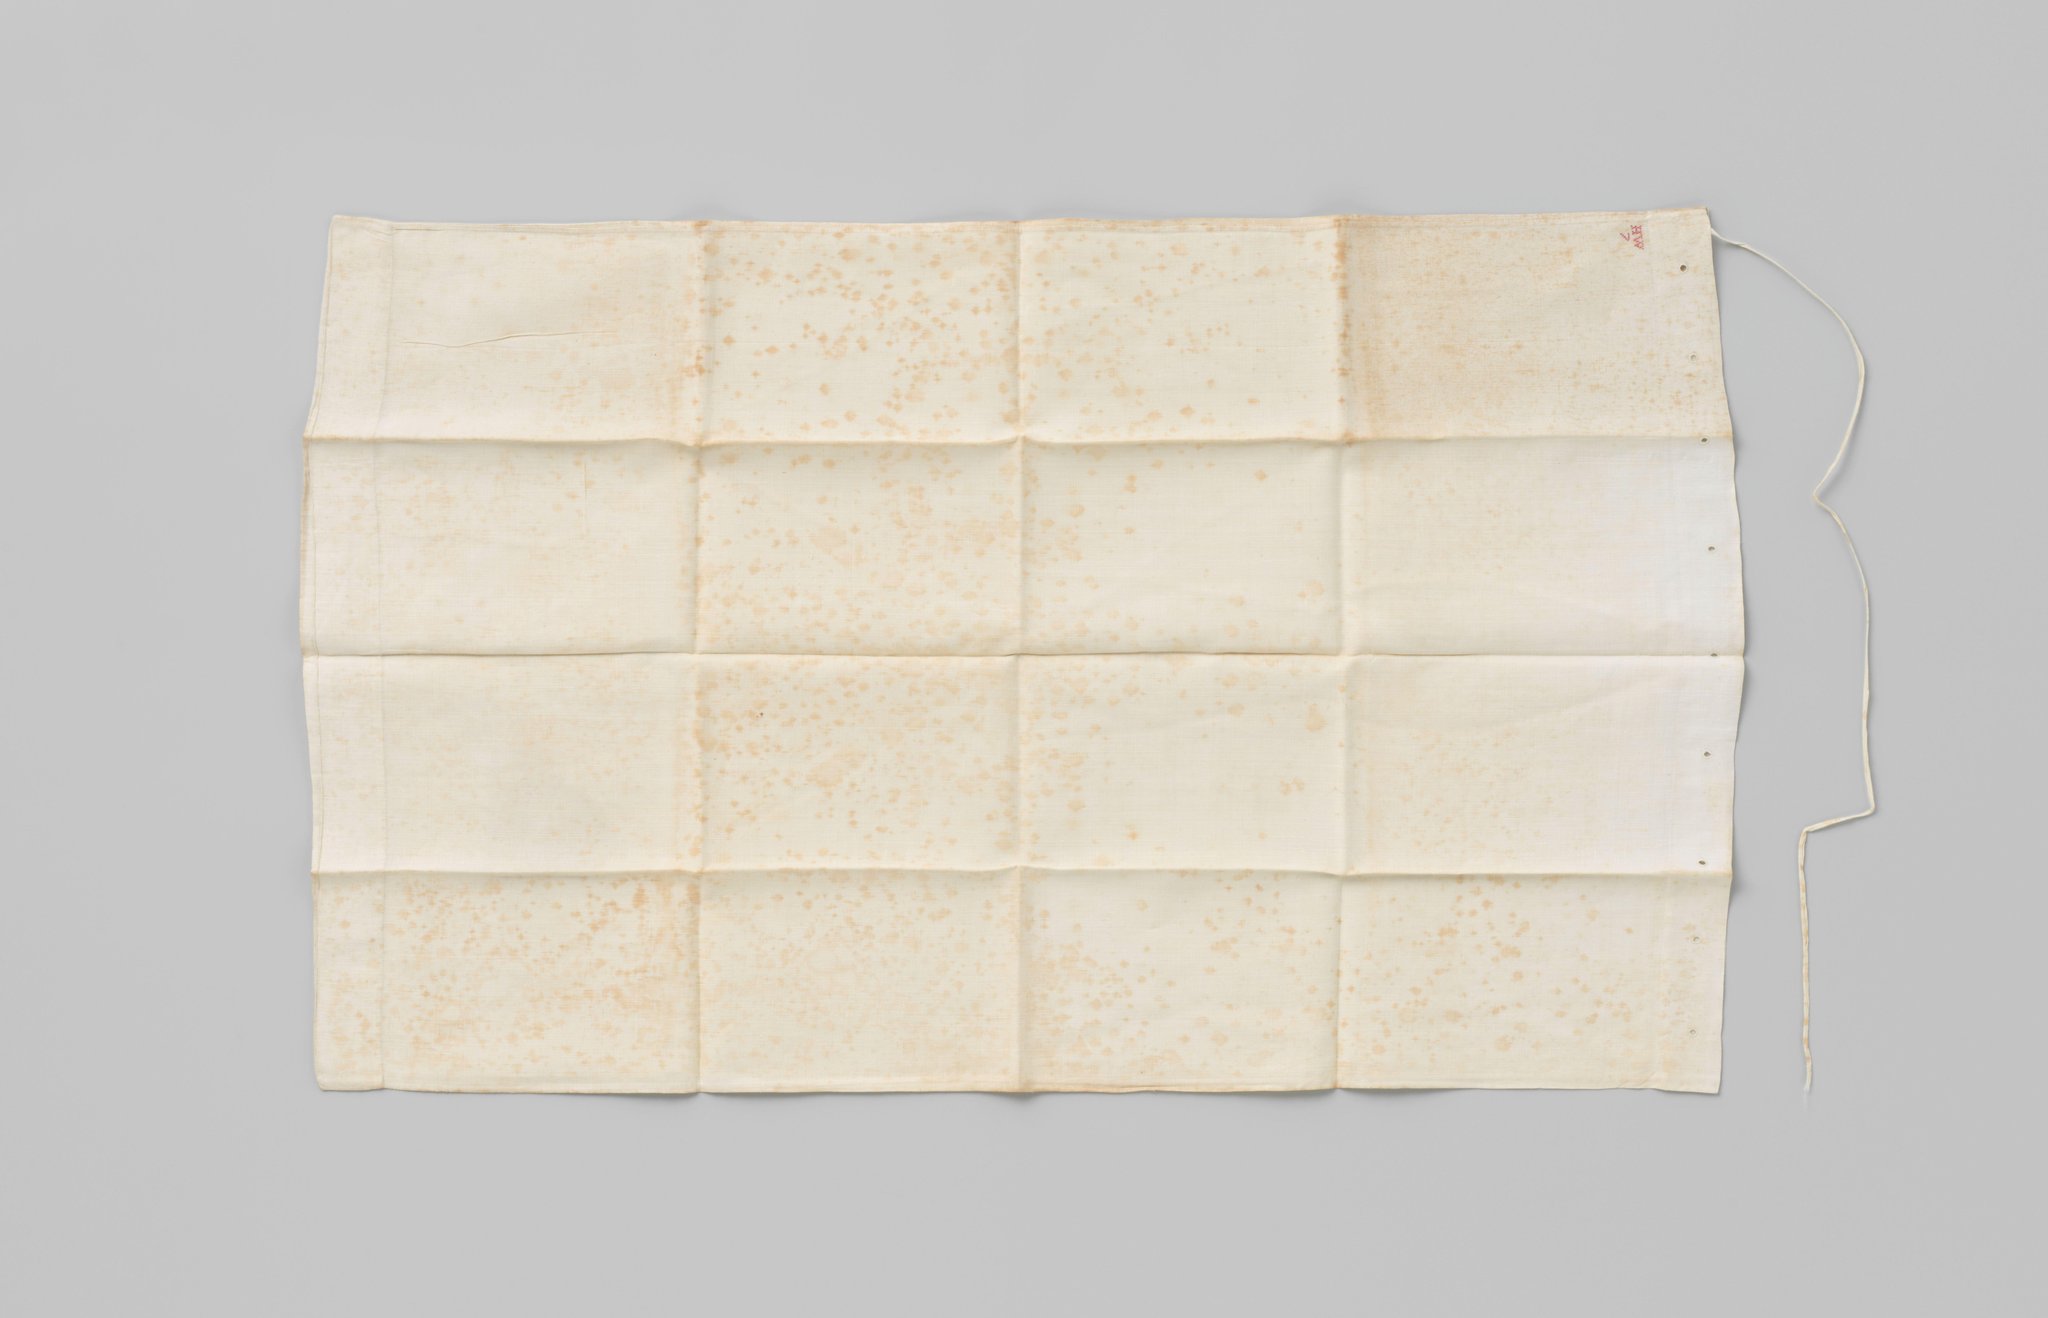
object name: lendensloop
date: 1820-1870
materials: linen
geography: northern netherlands